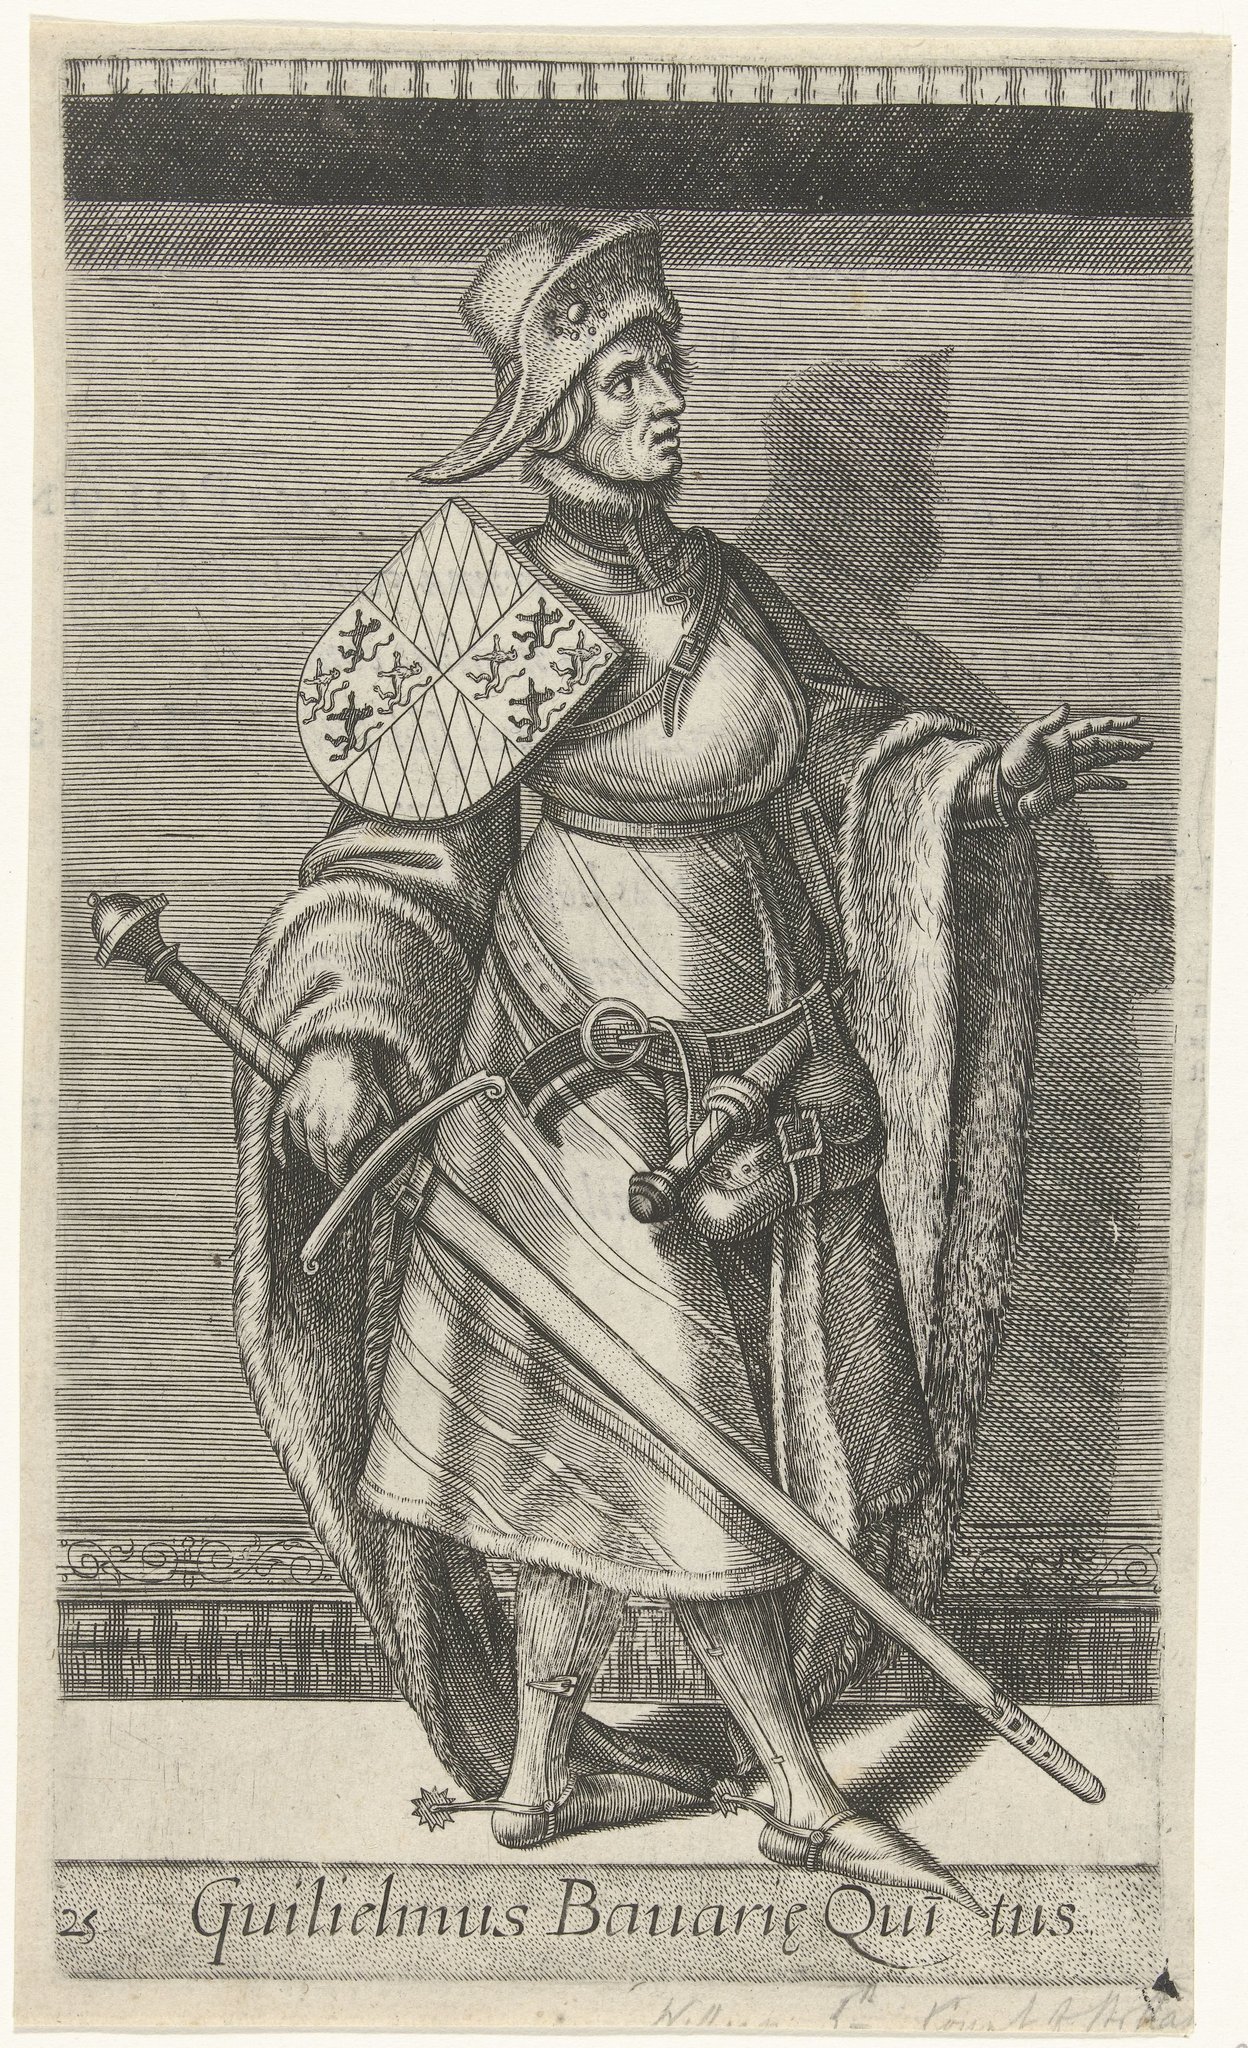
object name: book illustration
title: Guilielmus Bauarie Quitus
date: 1578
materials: paper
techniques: engraving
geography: antwerp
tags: earl, willem v van holland (graaf van holland en zeeland)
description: Willem V, graaf van Holland, Henegouwen en Zeeland. Staande, ten voeten uit. Hij draagt een zwaard in zijn rechterhand. Op zijn linkerschouder het wapenschild van Holland, Zeeland en Henegouwen. De prent dient als een illustratie bij een boek over de geschiedenis van de graven van Holland.